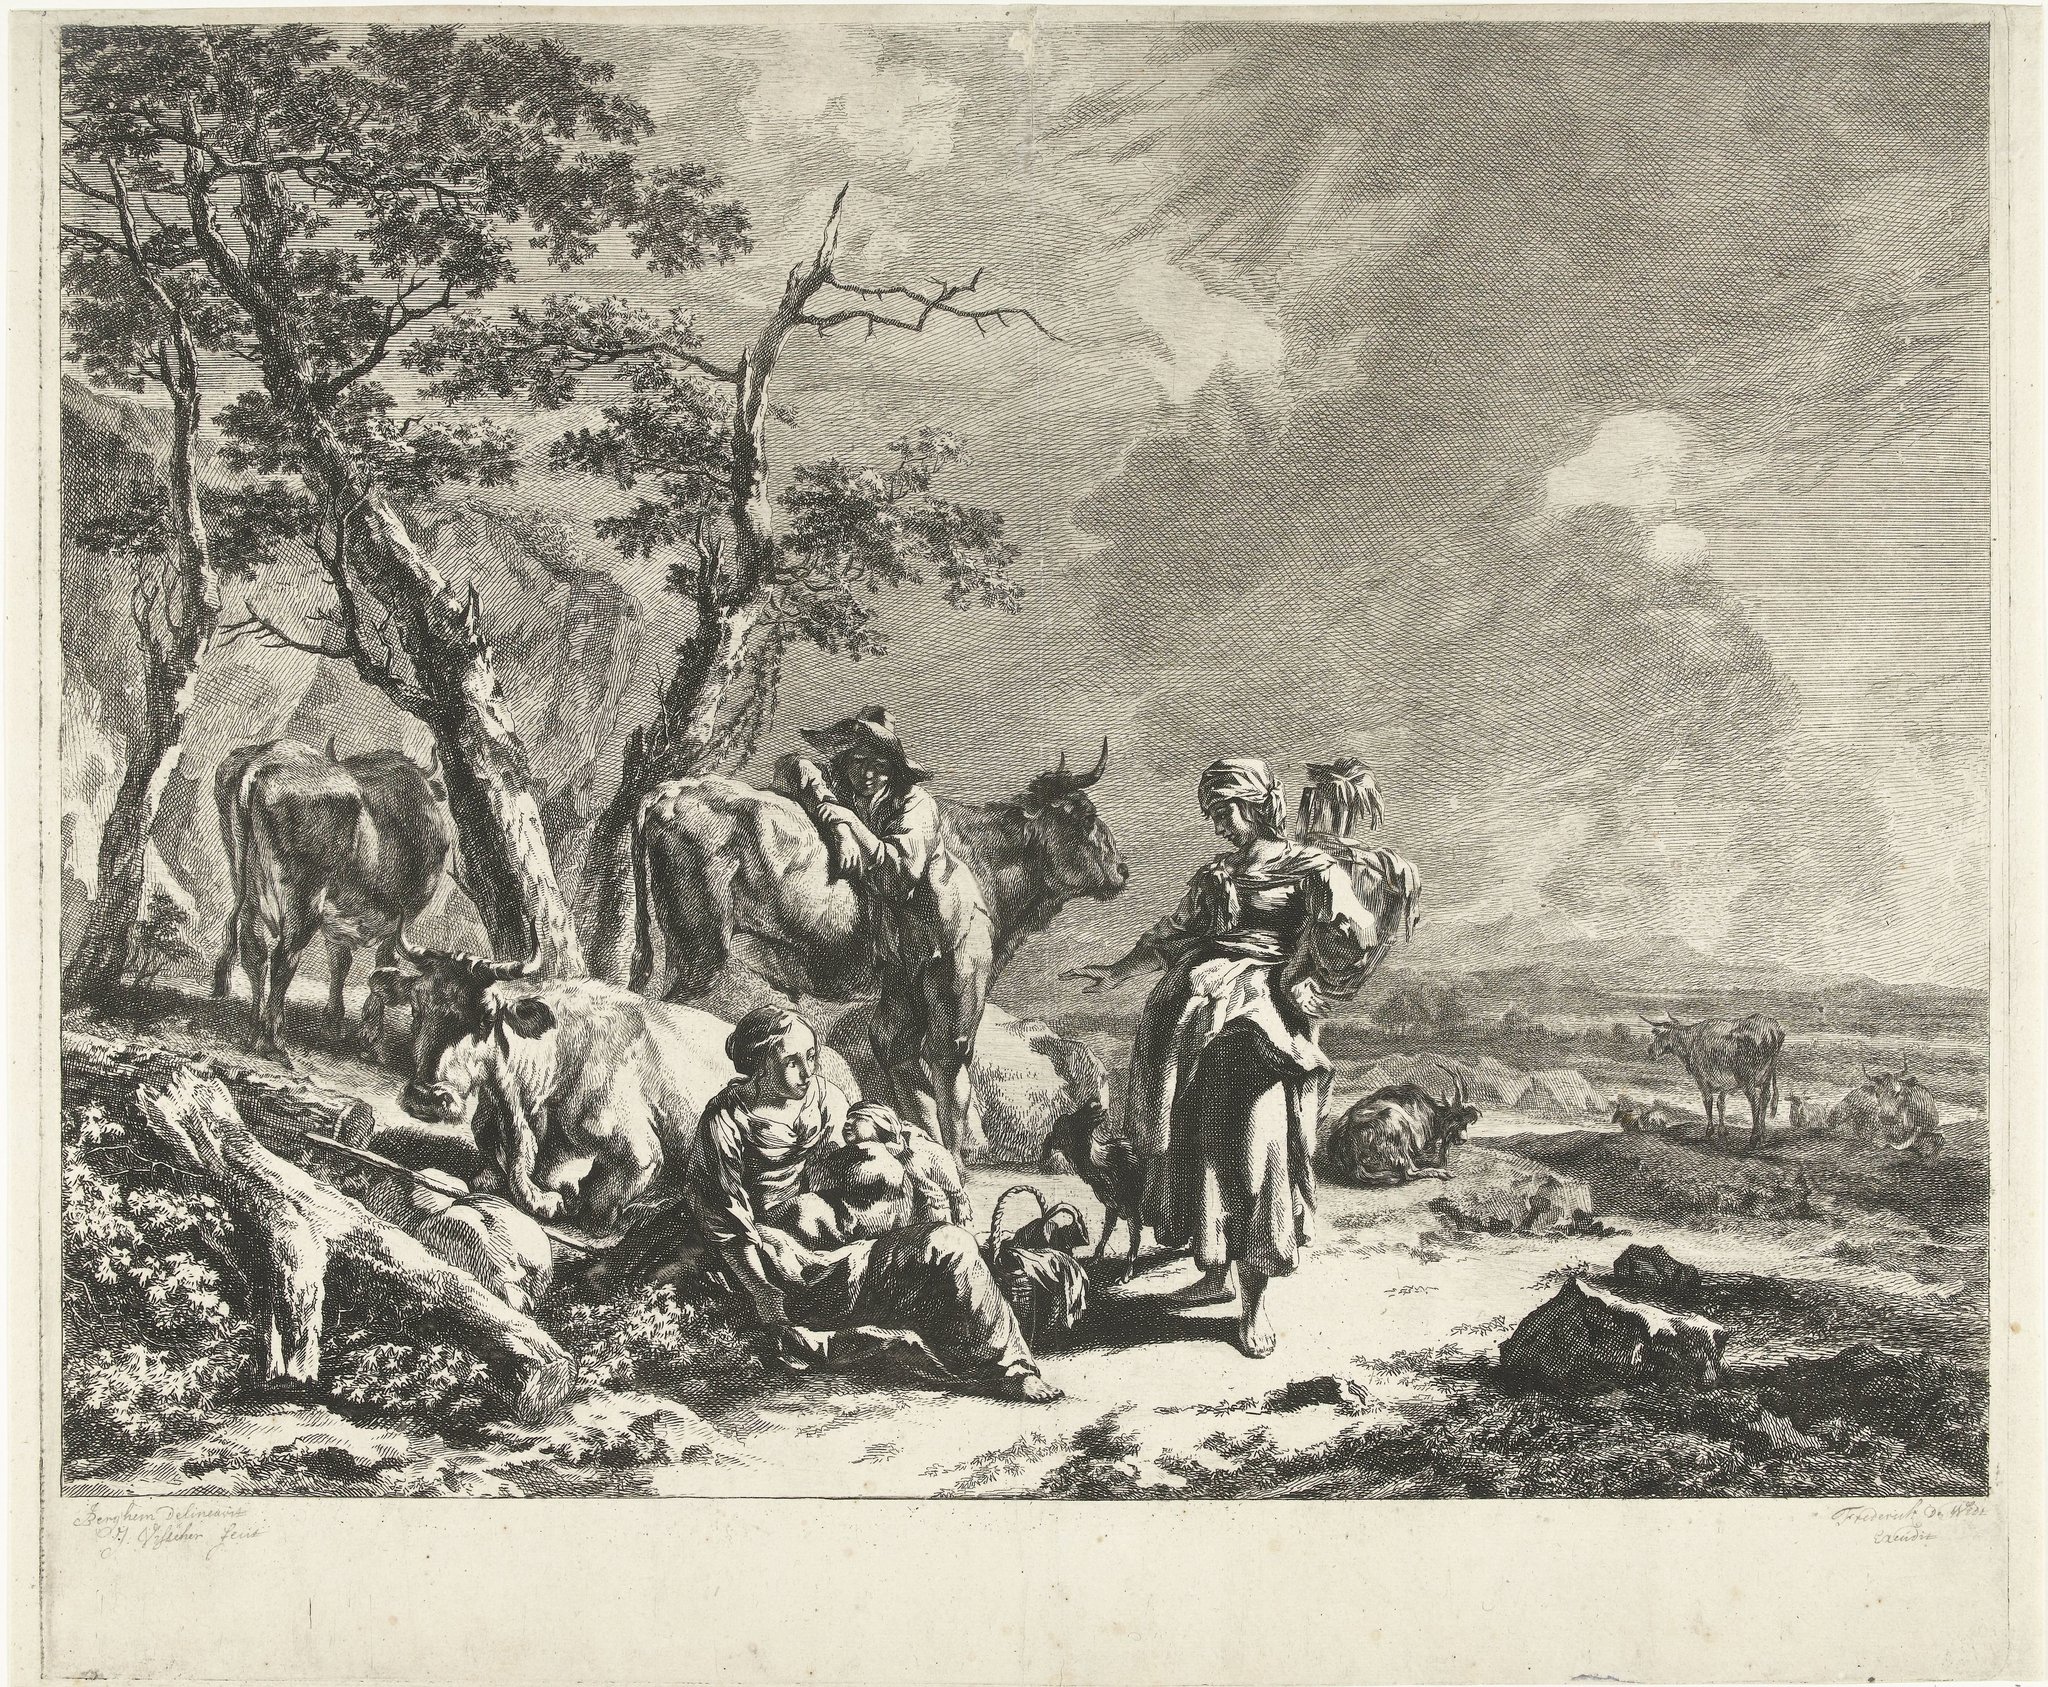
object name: print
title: Middag: herdersfamilie rust met kudde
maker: dancker danckerts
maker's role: print maker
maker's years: 1633-1666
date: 1660-1666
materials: paper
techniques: etching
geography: amsterdam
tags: herding, herdsman, herdswoman, shepherd, shepherdess, cowherd, etc., rocks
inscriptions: collector's mark: Lugt 240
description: Herdersfamilie rust met kudde koeien bij bomen. Herderin zit met kind op schoot. Prent nummer 2 uit serie van vier prenten met tijden van de dag.